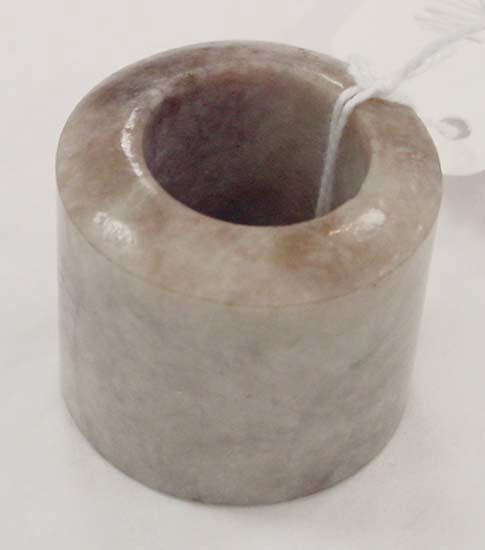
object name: ring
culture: chinese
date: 1801-1900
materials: jade